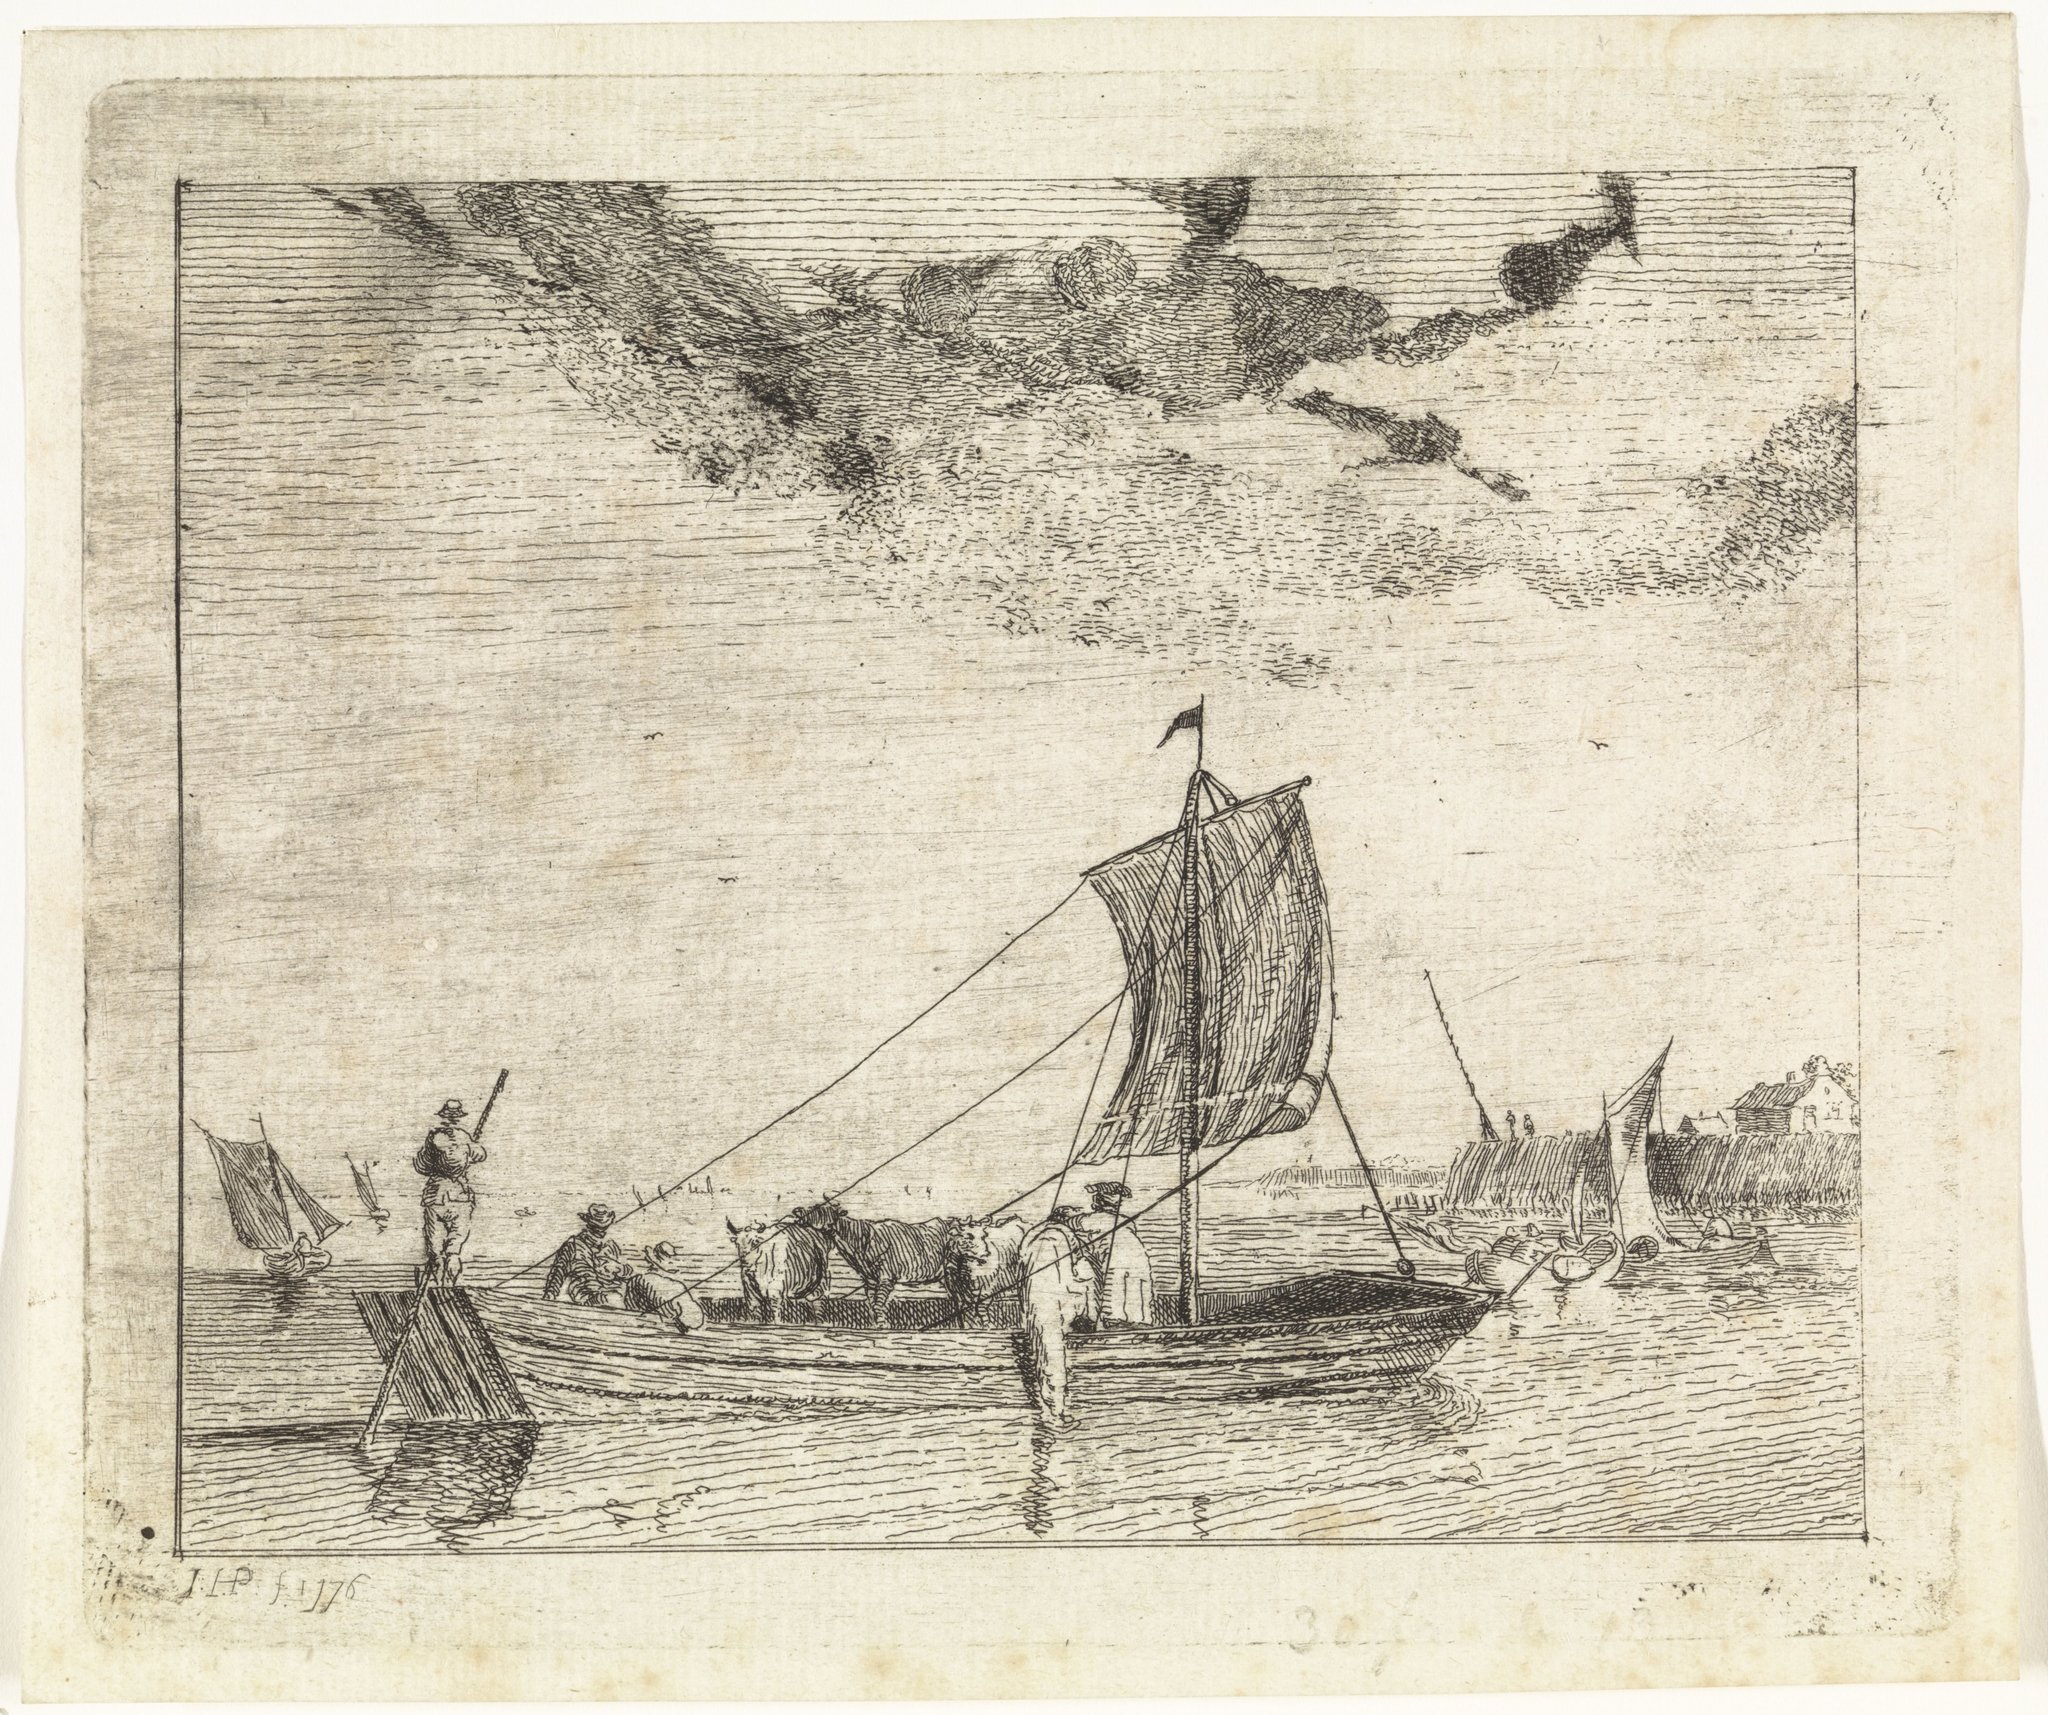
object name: print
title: Platte schuit met vee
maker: johannes huibert prins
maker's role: draughtsman, painter, print maker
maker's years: 1757-1806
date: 1776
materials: paper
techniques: etching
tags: cattle, ferry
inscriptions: inscription: ‘3. J.H. Prins’, collector's mark: Lugt 2228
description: Op een platte schuit met gehesen zeil zitten twee mannen. De schipper staat met een duwboom achter op de boot. Op de schuit staan ook drie koeien en een ruiter met zijn paard, dat zich voorover buigt naar het water op te drinken.